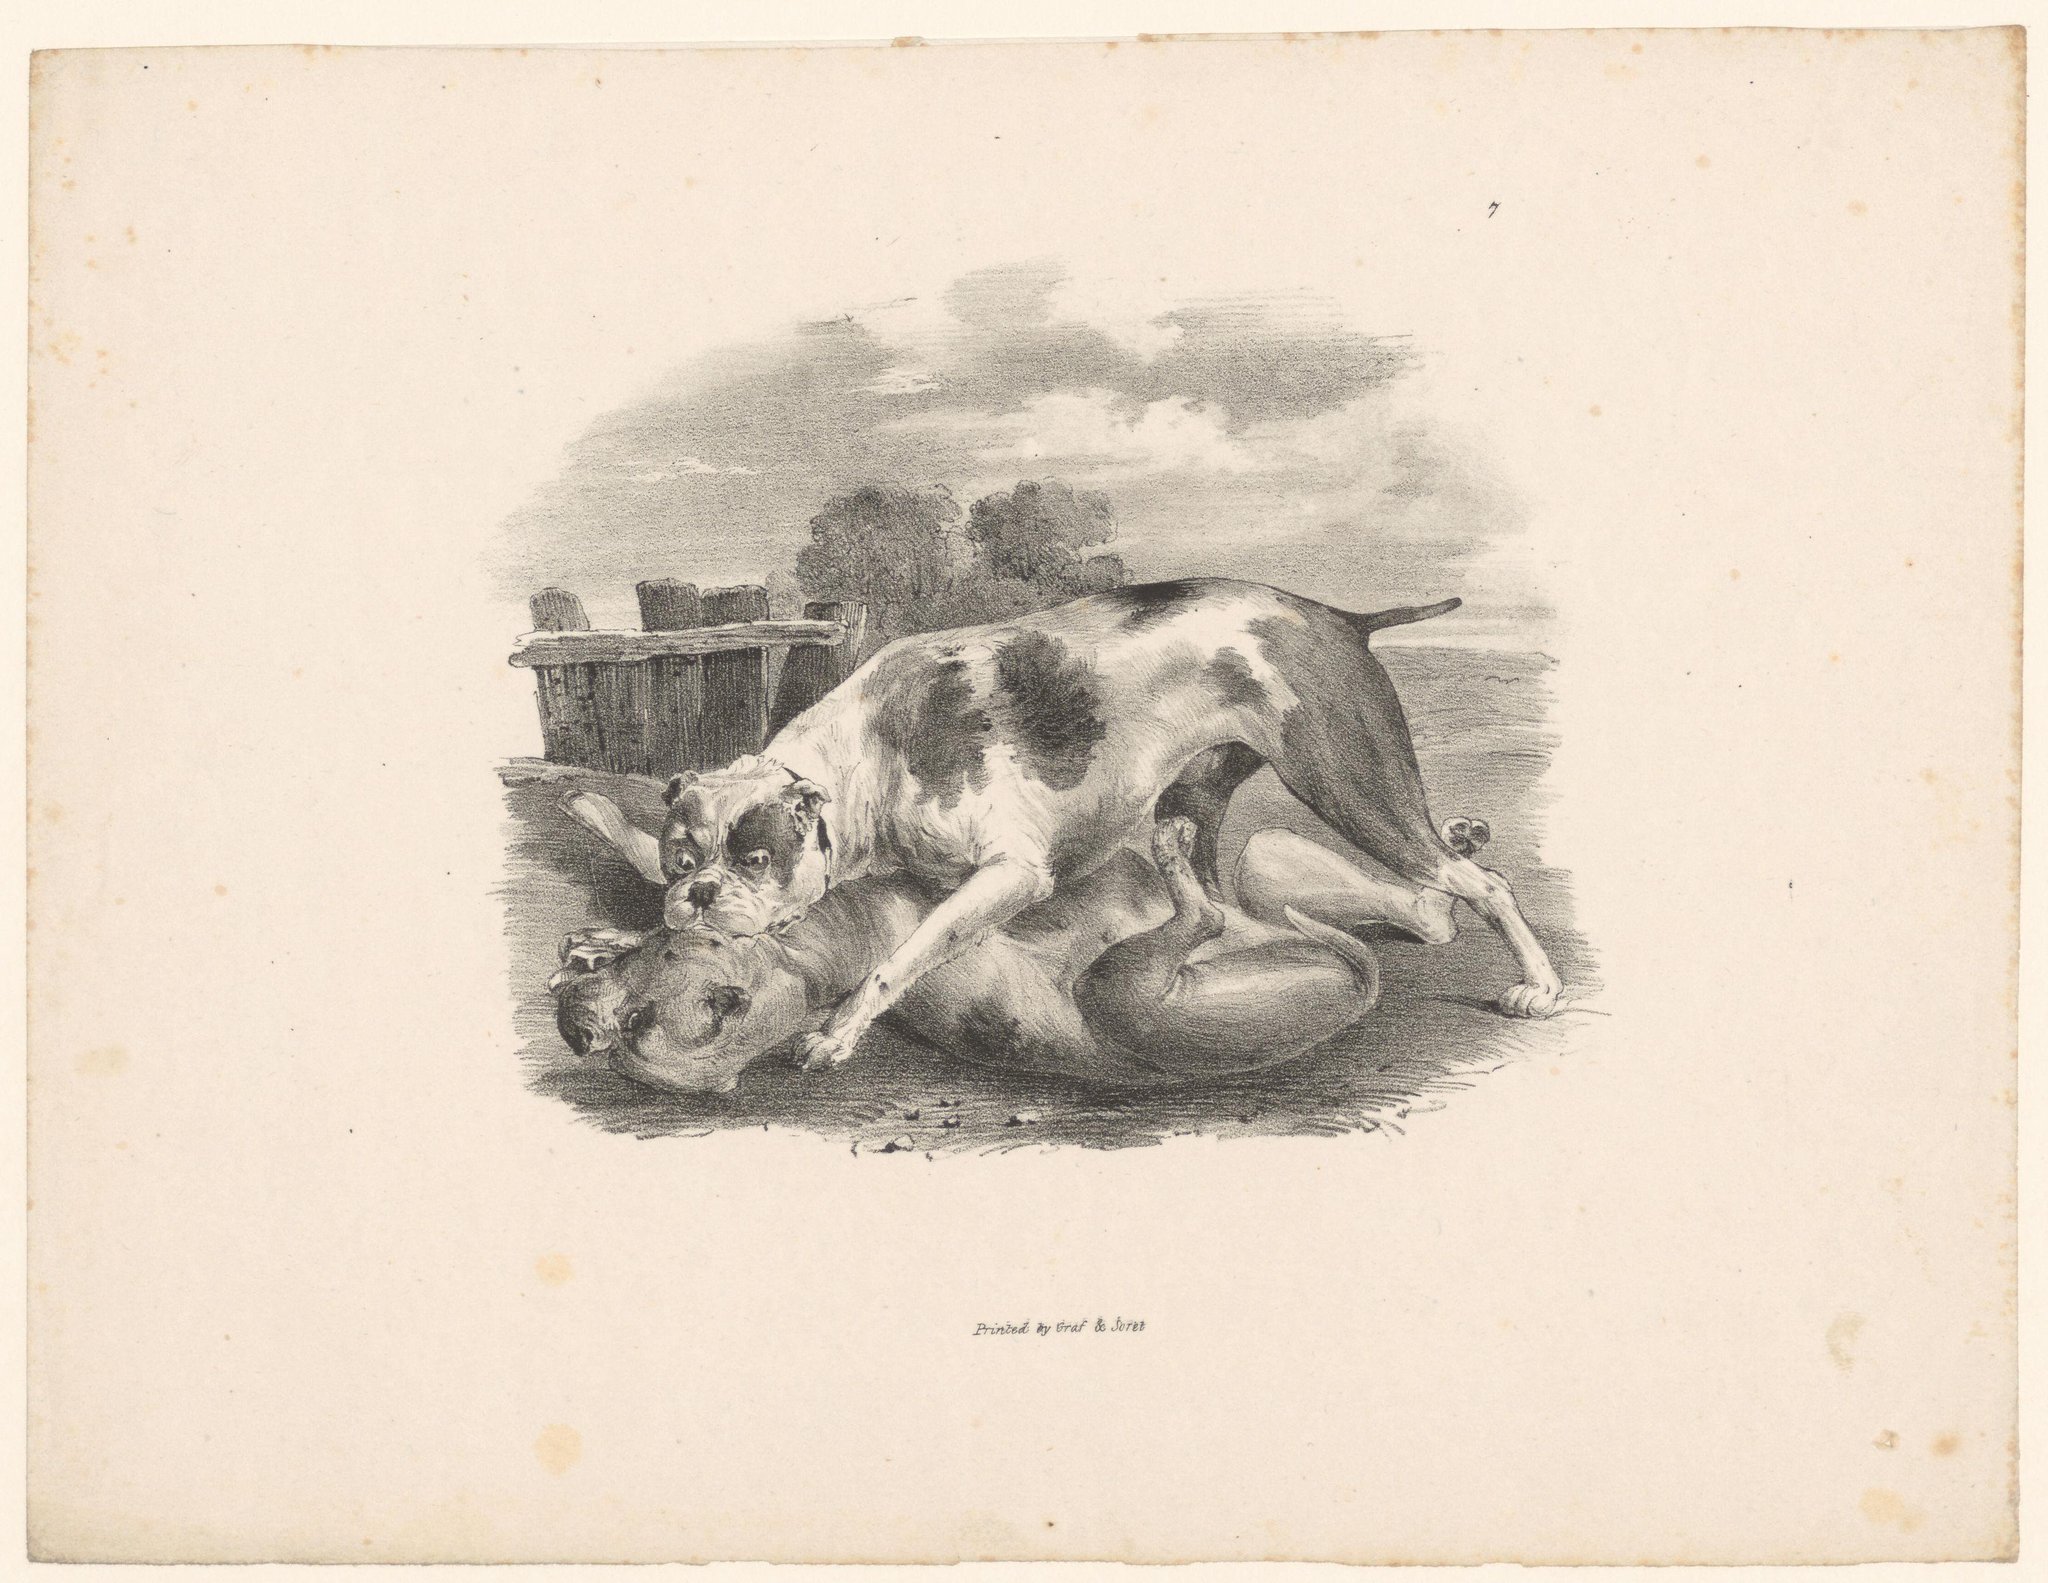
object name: print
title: Voorstellingen van honden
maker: james henry lynch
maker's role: print maker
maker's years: -1868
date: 1830-1838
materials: paper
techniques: lithograph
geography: london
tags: aggressive relationships, enmity, animosity, dog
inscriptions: collector's mark: Lugt 2233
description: Prent maakt waarschijnlijk deel uit van een serie met diervoorstellingen. Over deze serie is verder niets bekend. Het betreft voornamelijk voorstellingen van honden.